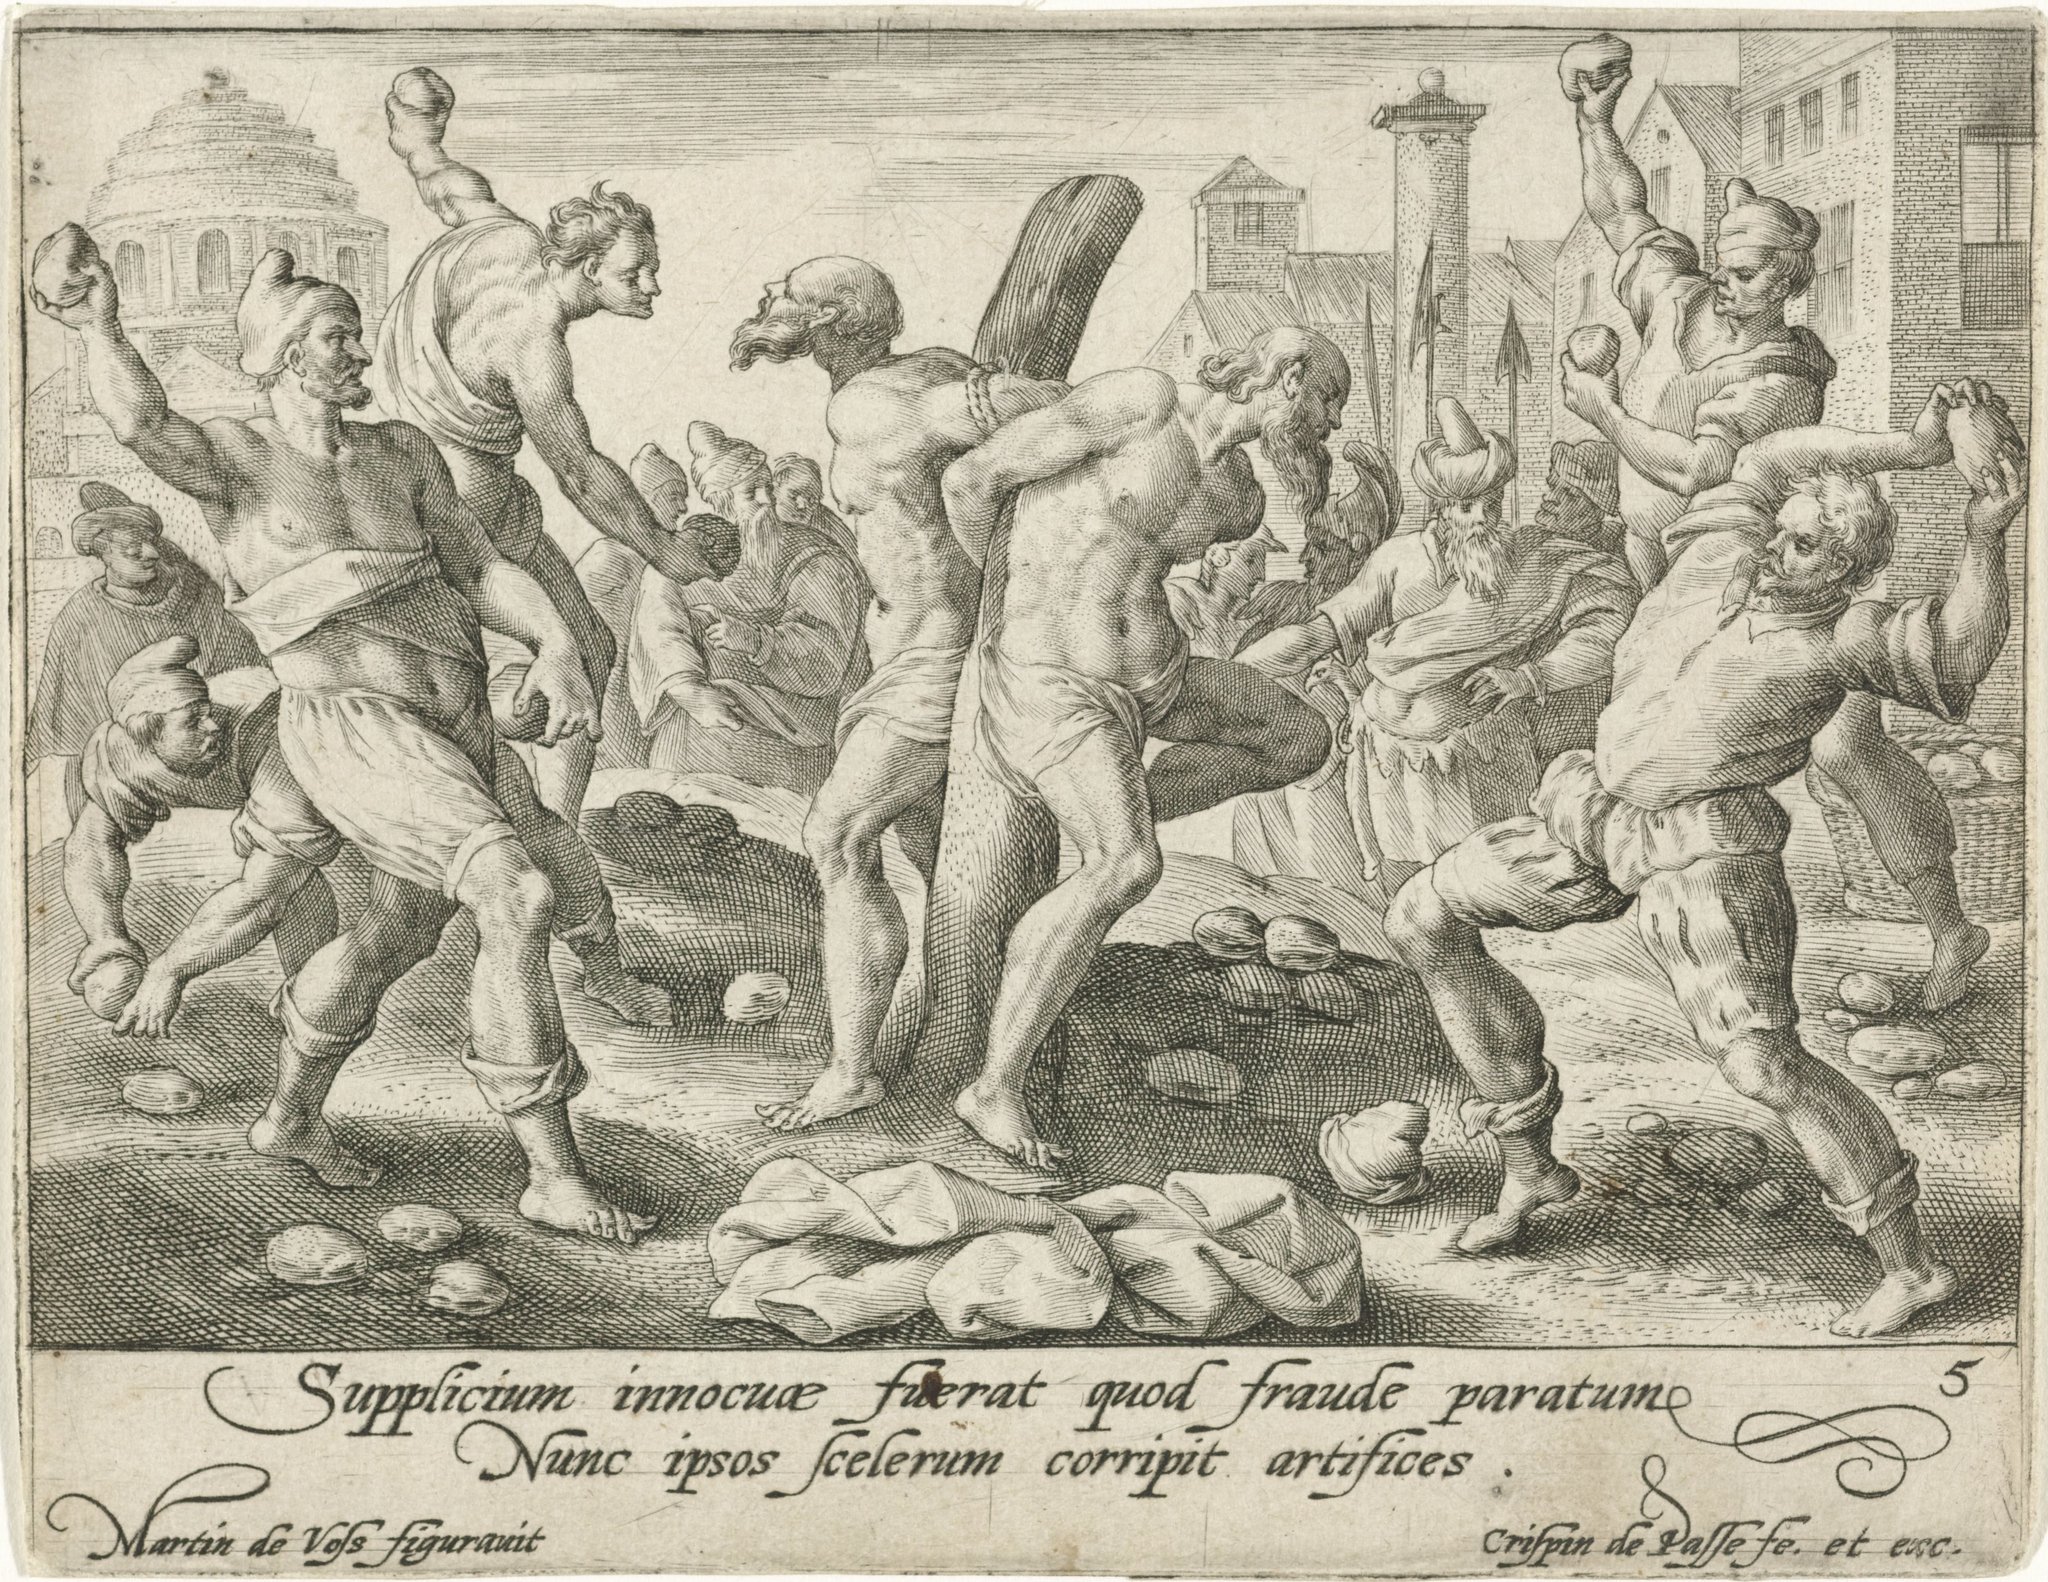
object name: print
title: Steniging van de ouderlingen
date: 1574-1637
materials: paper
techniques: engraving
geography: antwerp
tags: the elders are stoned to death ~ story of susanna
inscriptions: collector's mark: Lugt 964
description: De twee ouderlingen zijn aan een boom vastgebonden en worden door vier beulen gestenigd. In de marge een tweeregelig onderschrift in het Latijn. Vijfde prent uit een serie van zes over de geschiedenis van Susanna.